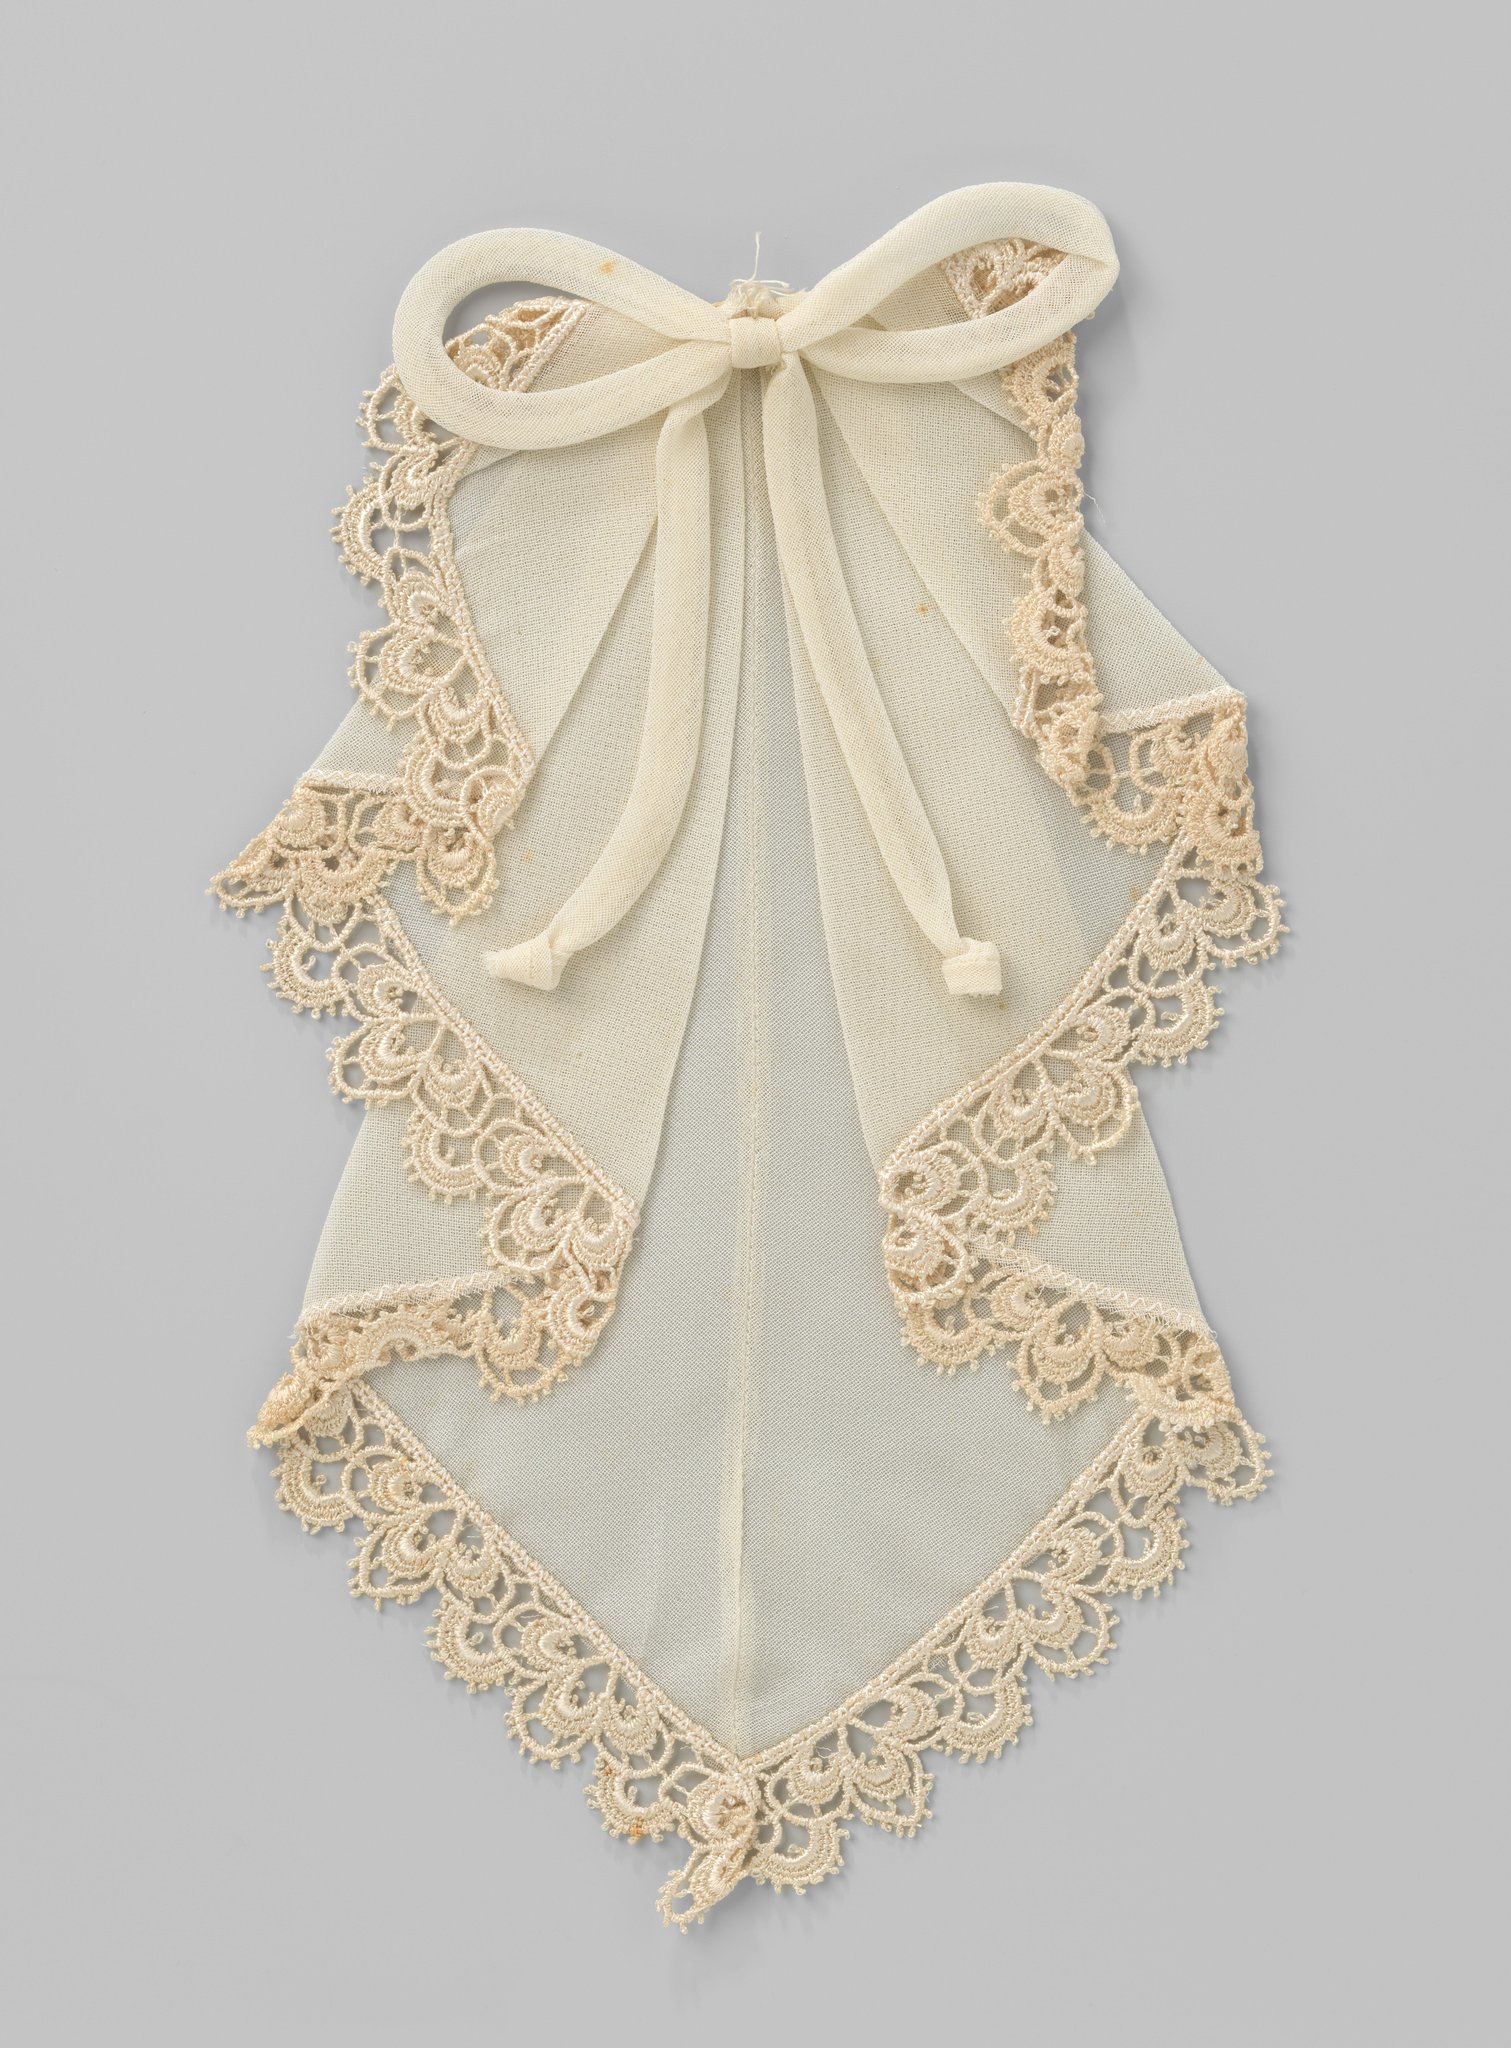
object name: band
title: Bef van wit textiel met geschulpte rand kant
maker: Anonymous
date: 1875-1925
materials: textile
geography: europe